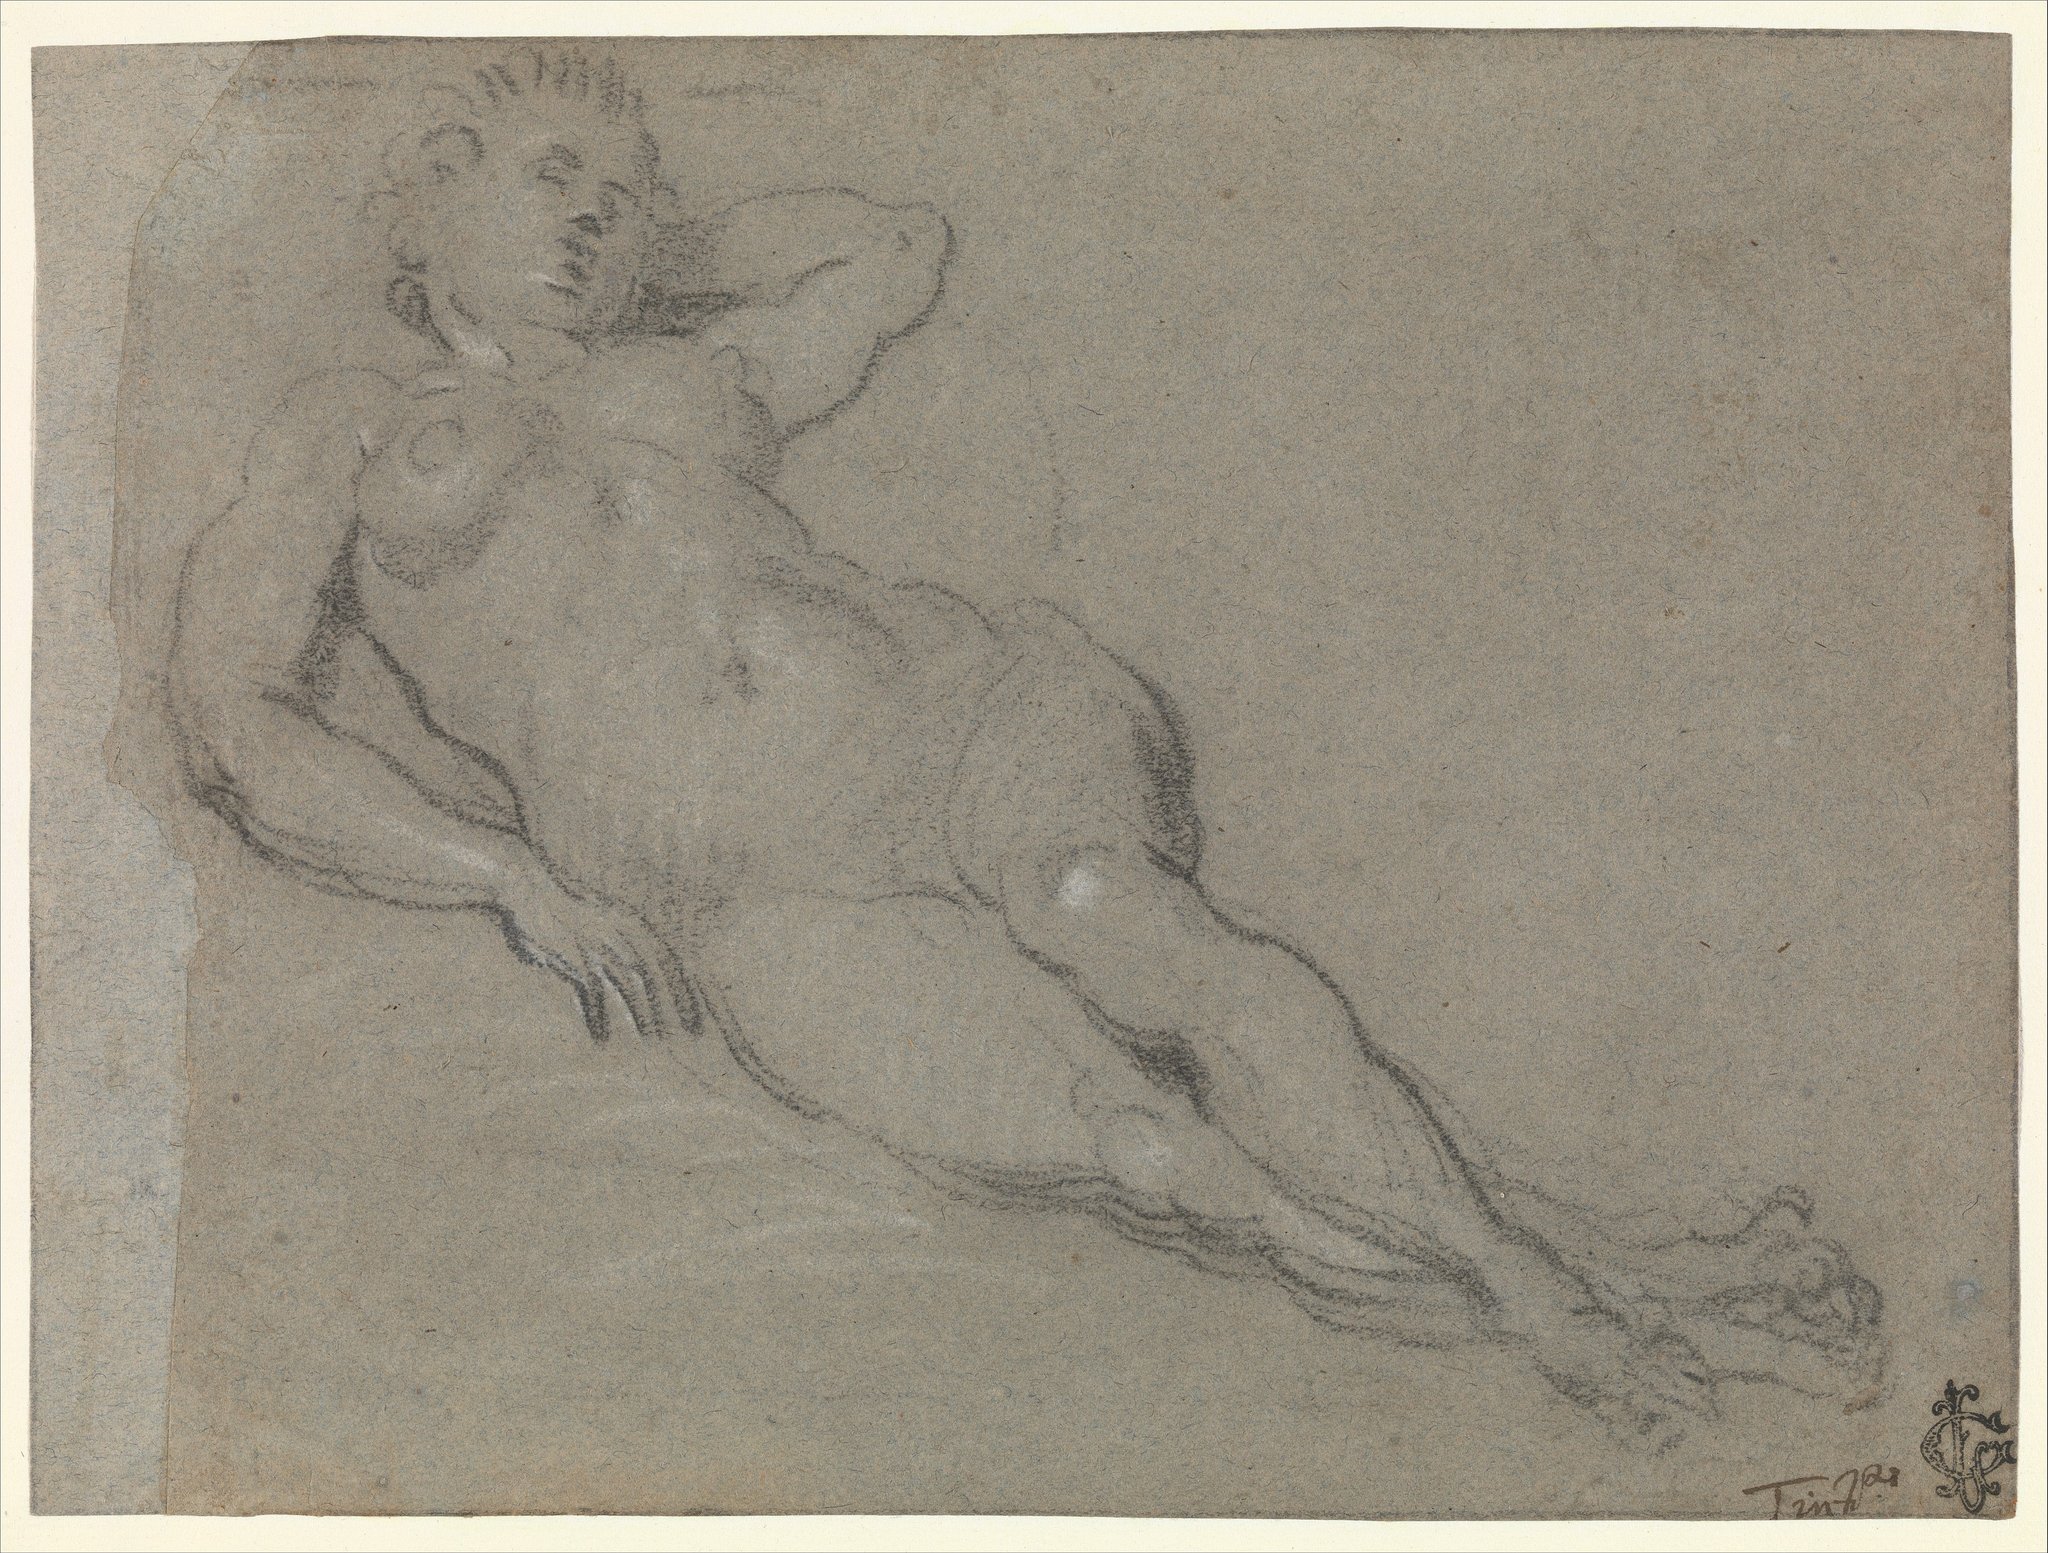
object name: drawing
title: Reclining Female Nude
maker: domenico tintoretto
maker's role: artist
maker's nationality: italian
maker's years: 1560-1635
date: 1601-1633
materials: chalk, paper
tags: female nudes